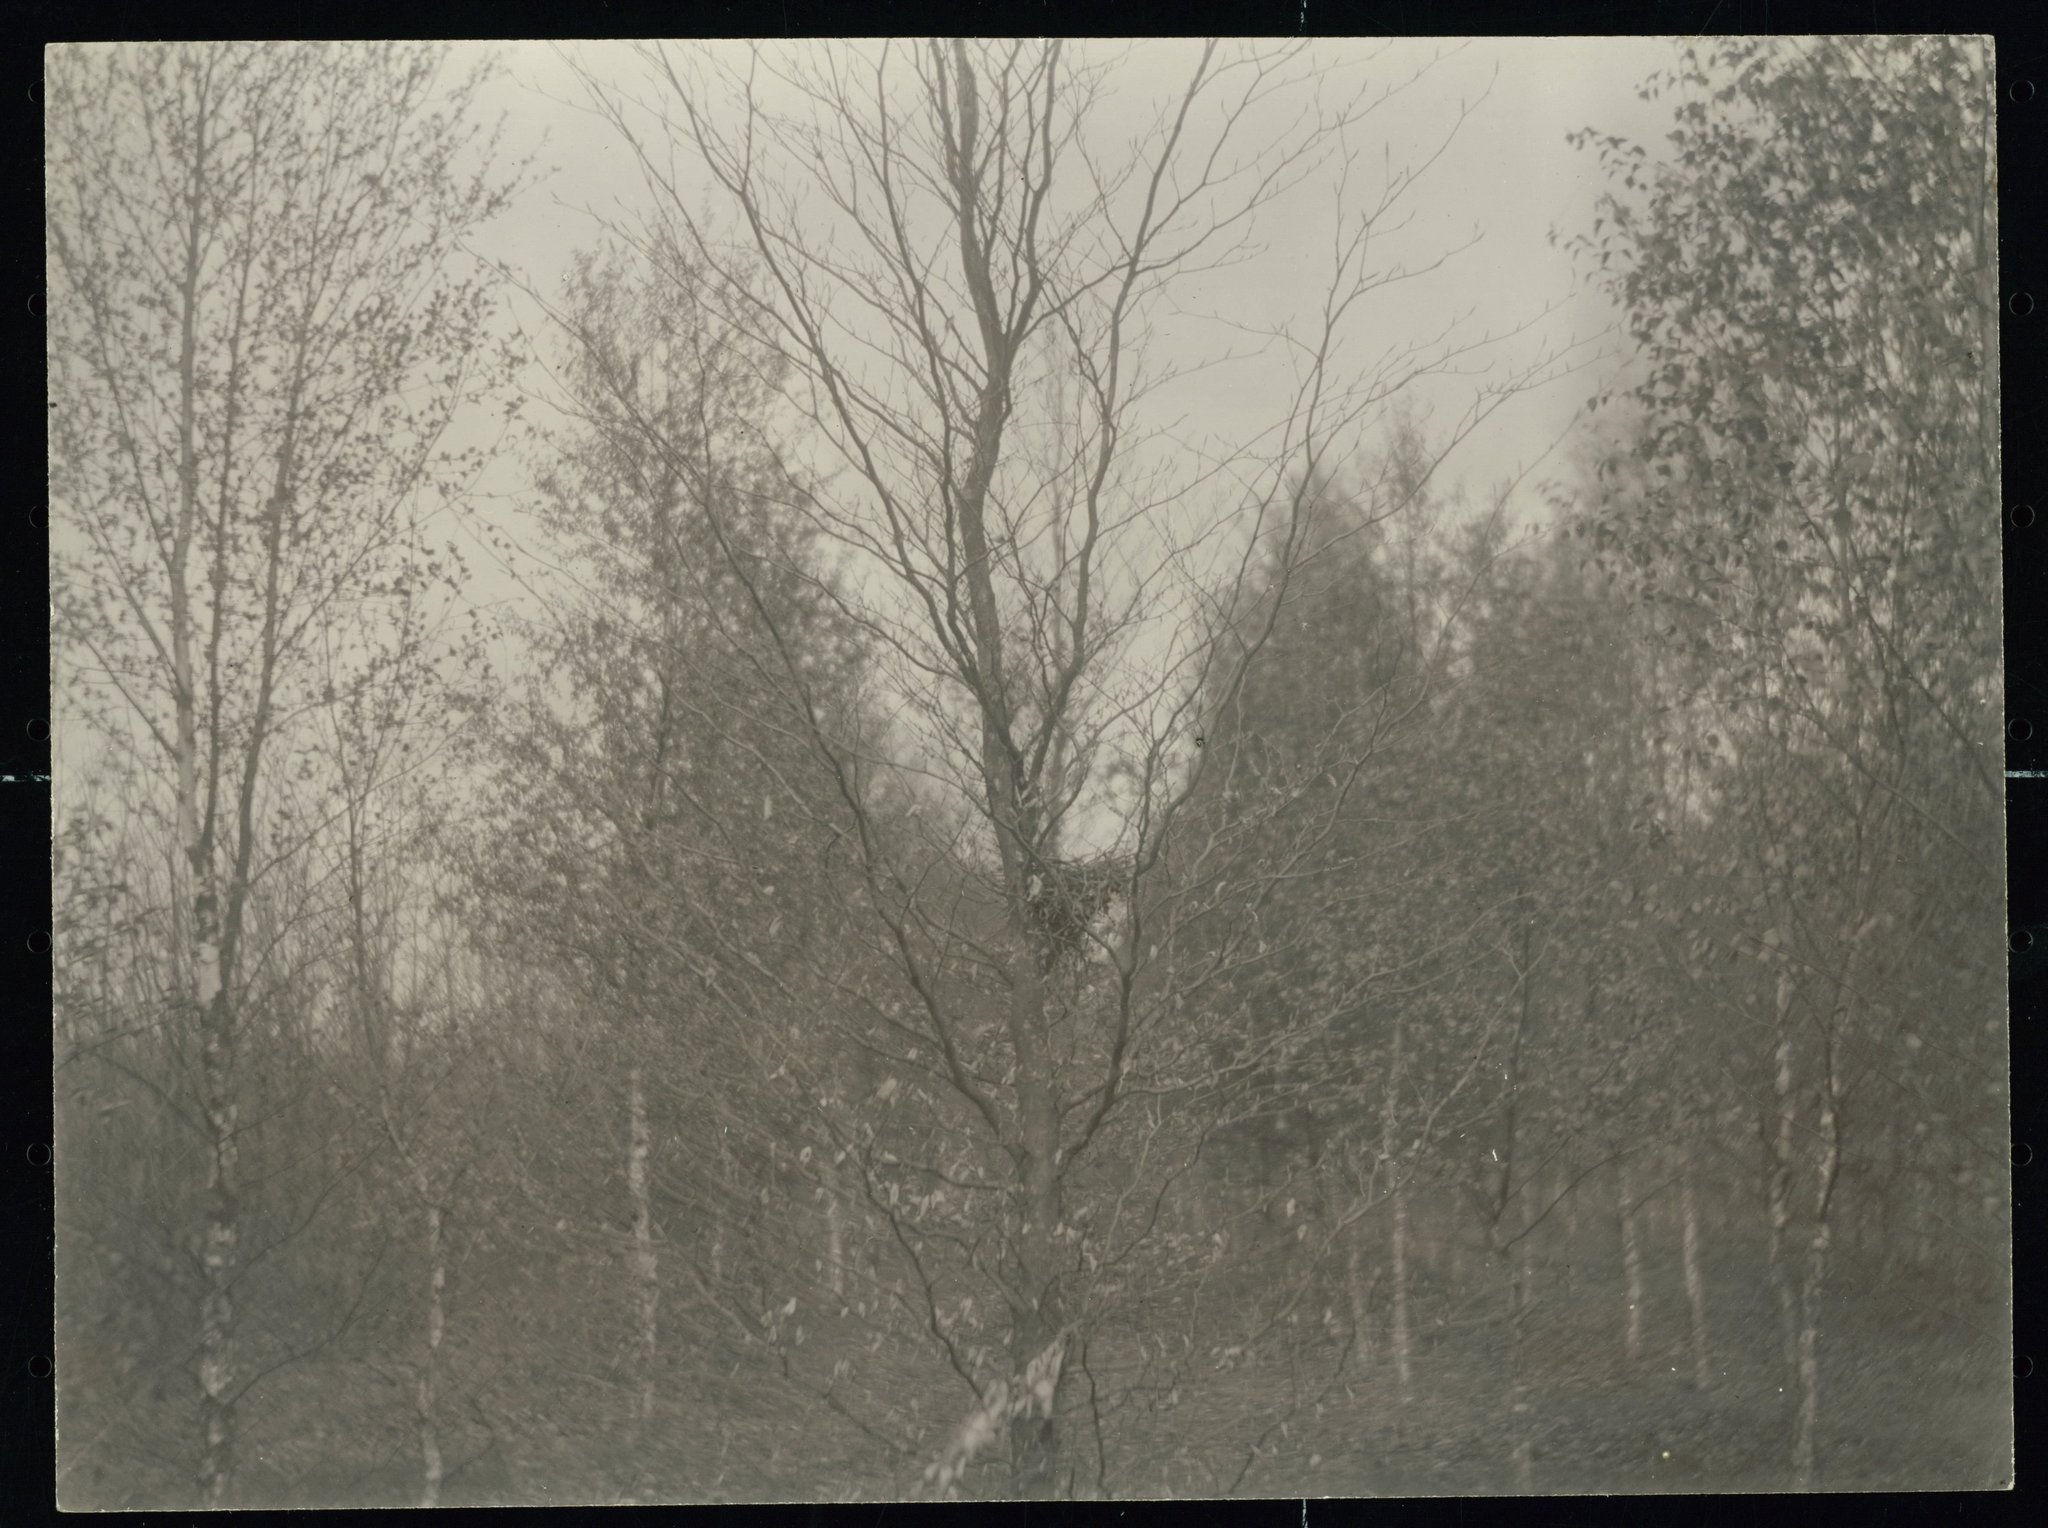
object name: photograph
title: Gezicht op een jong berkenbos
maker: richard tepe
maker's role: fotograaf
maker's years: 1864-1952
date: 1900-1930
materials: paper, photographic support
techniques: gelatin silver print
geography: netherlands